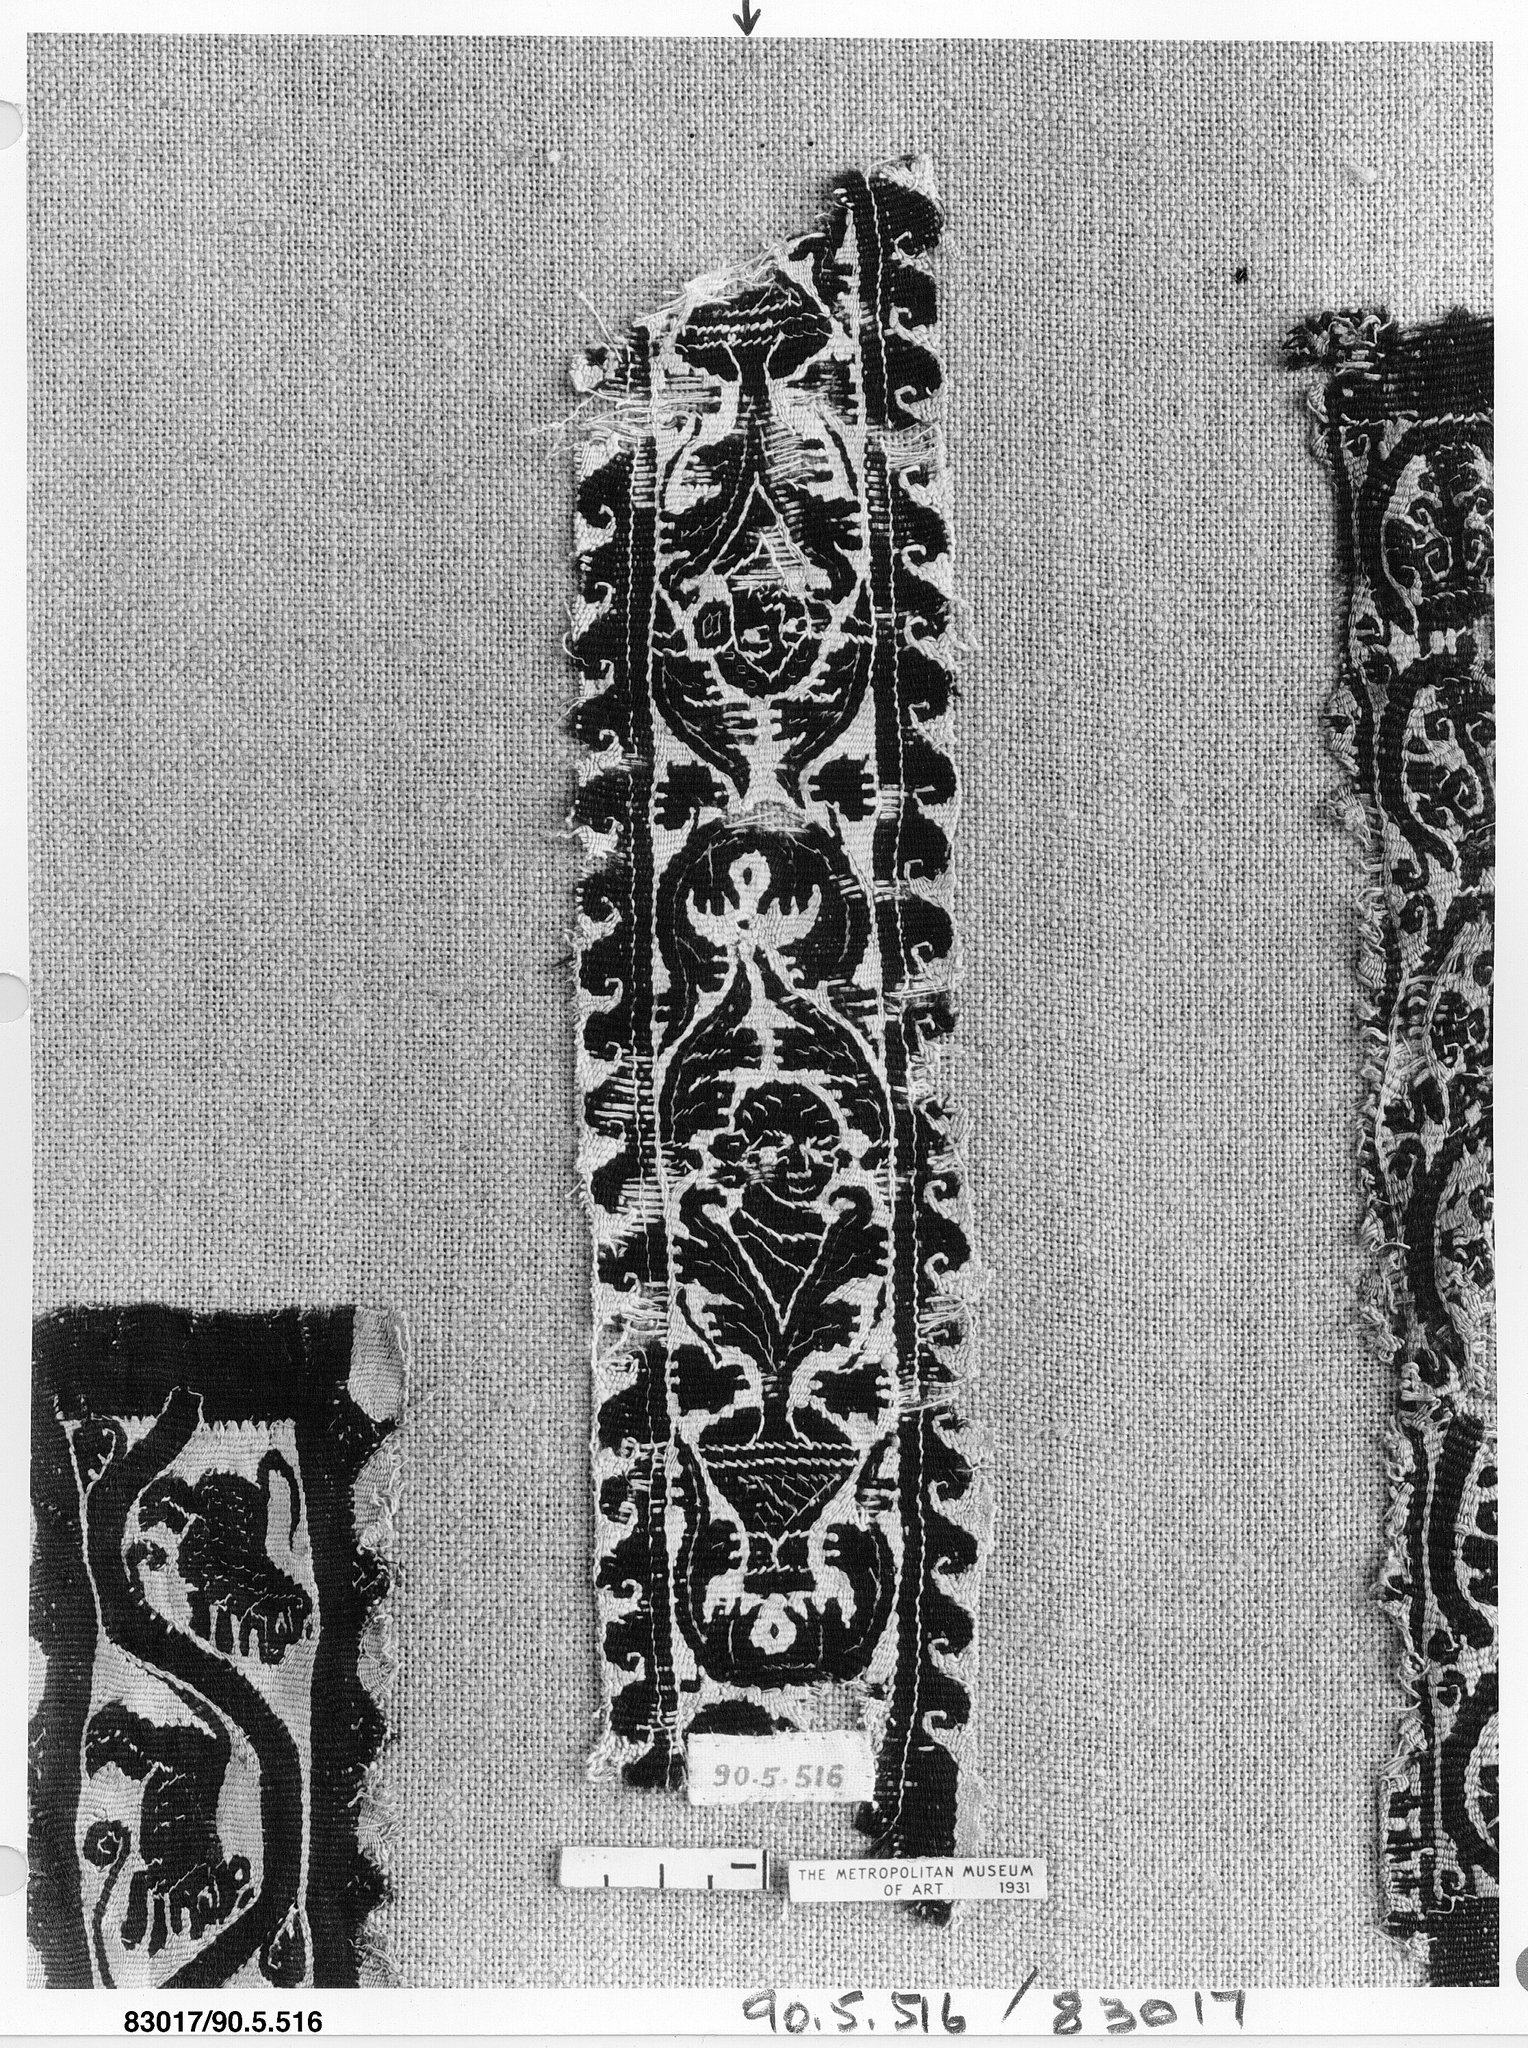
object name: textile fragment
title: Fragment of a Sleeve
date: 201-400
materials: linen, wool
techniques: weave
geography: egypt